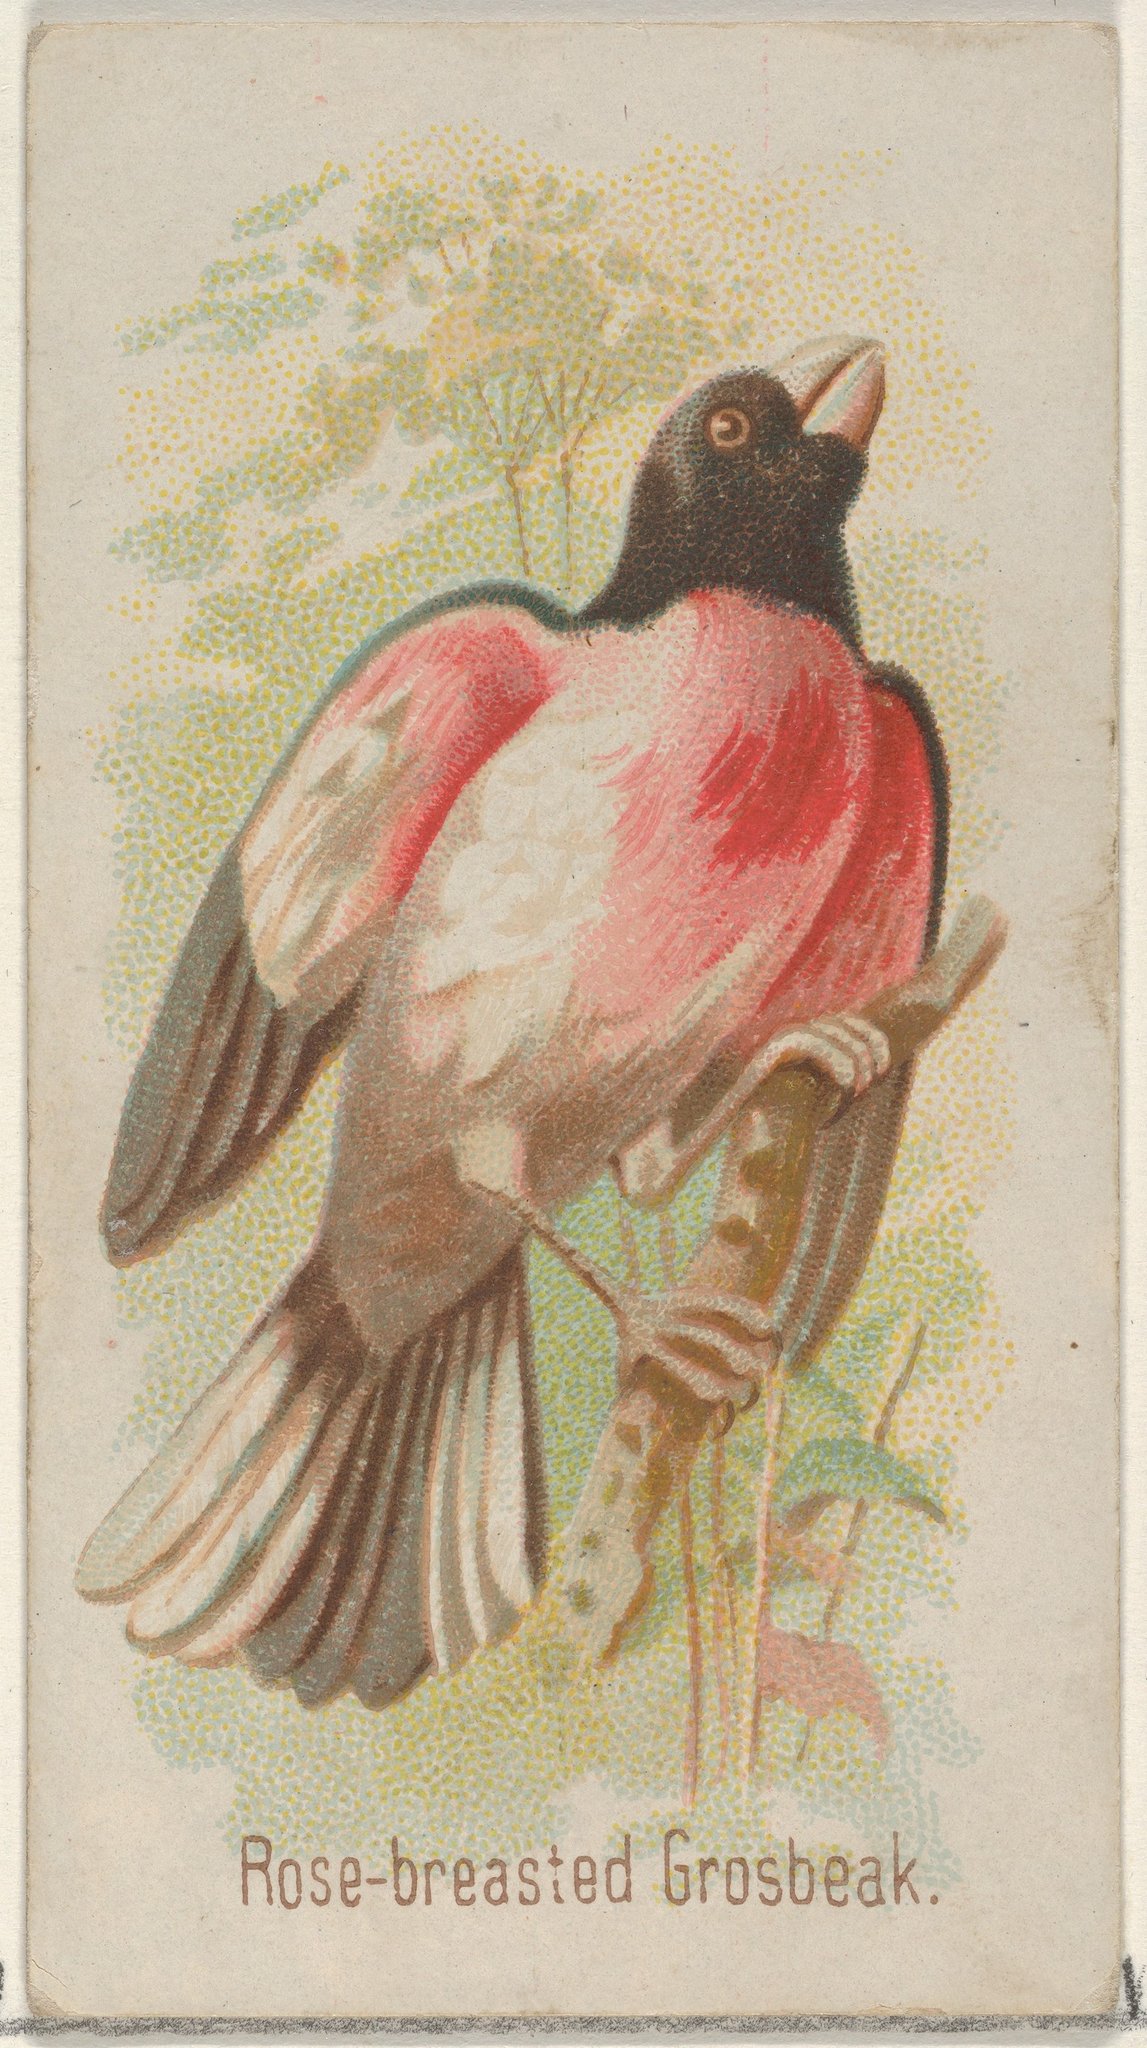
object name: print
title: Rose-breasted Grosbeak, from the Song Birds of the World series (N23) for Allen & Ginter Cigarettes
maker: allen & ginter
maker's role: publisher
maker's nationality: american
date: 1890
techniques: color lithograph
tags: birds